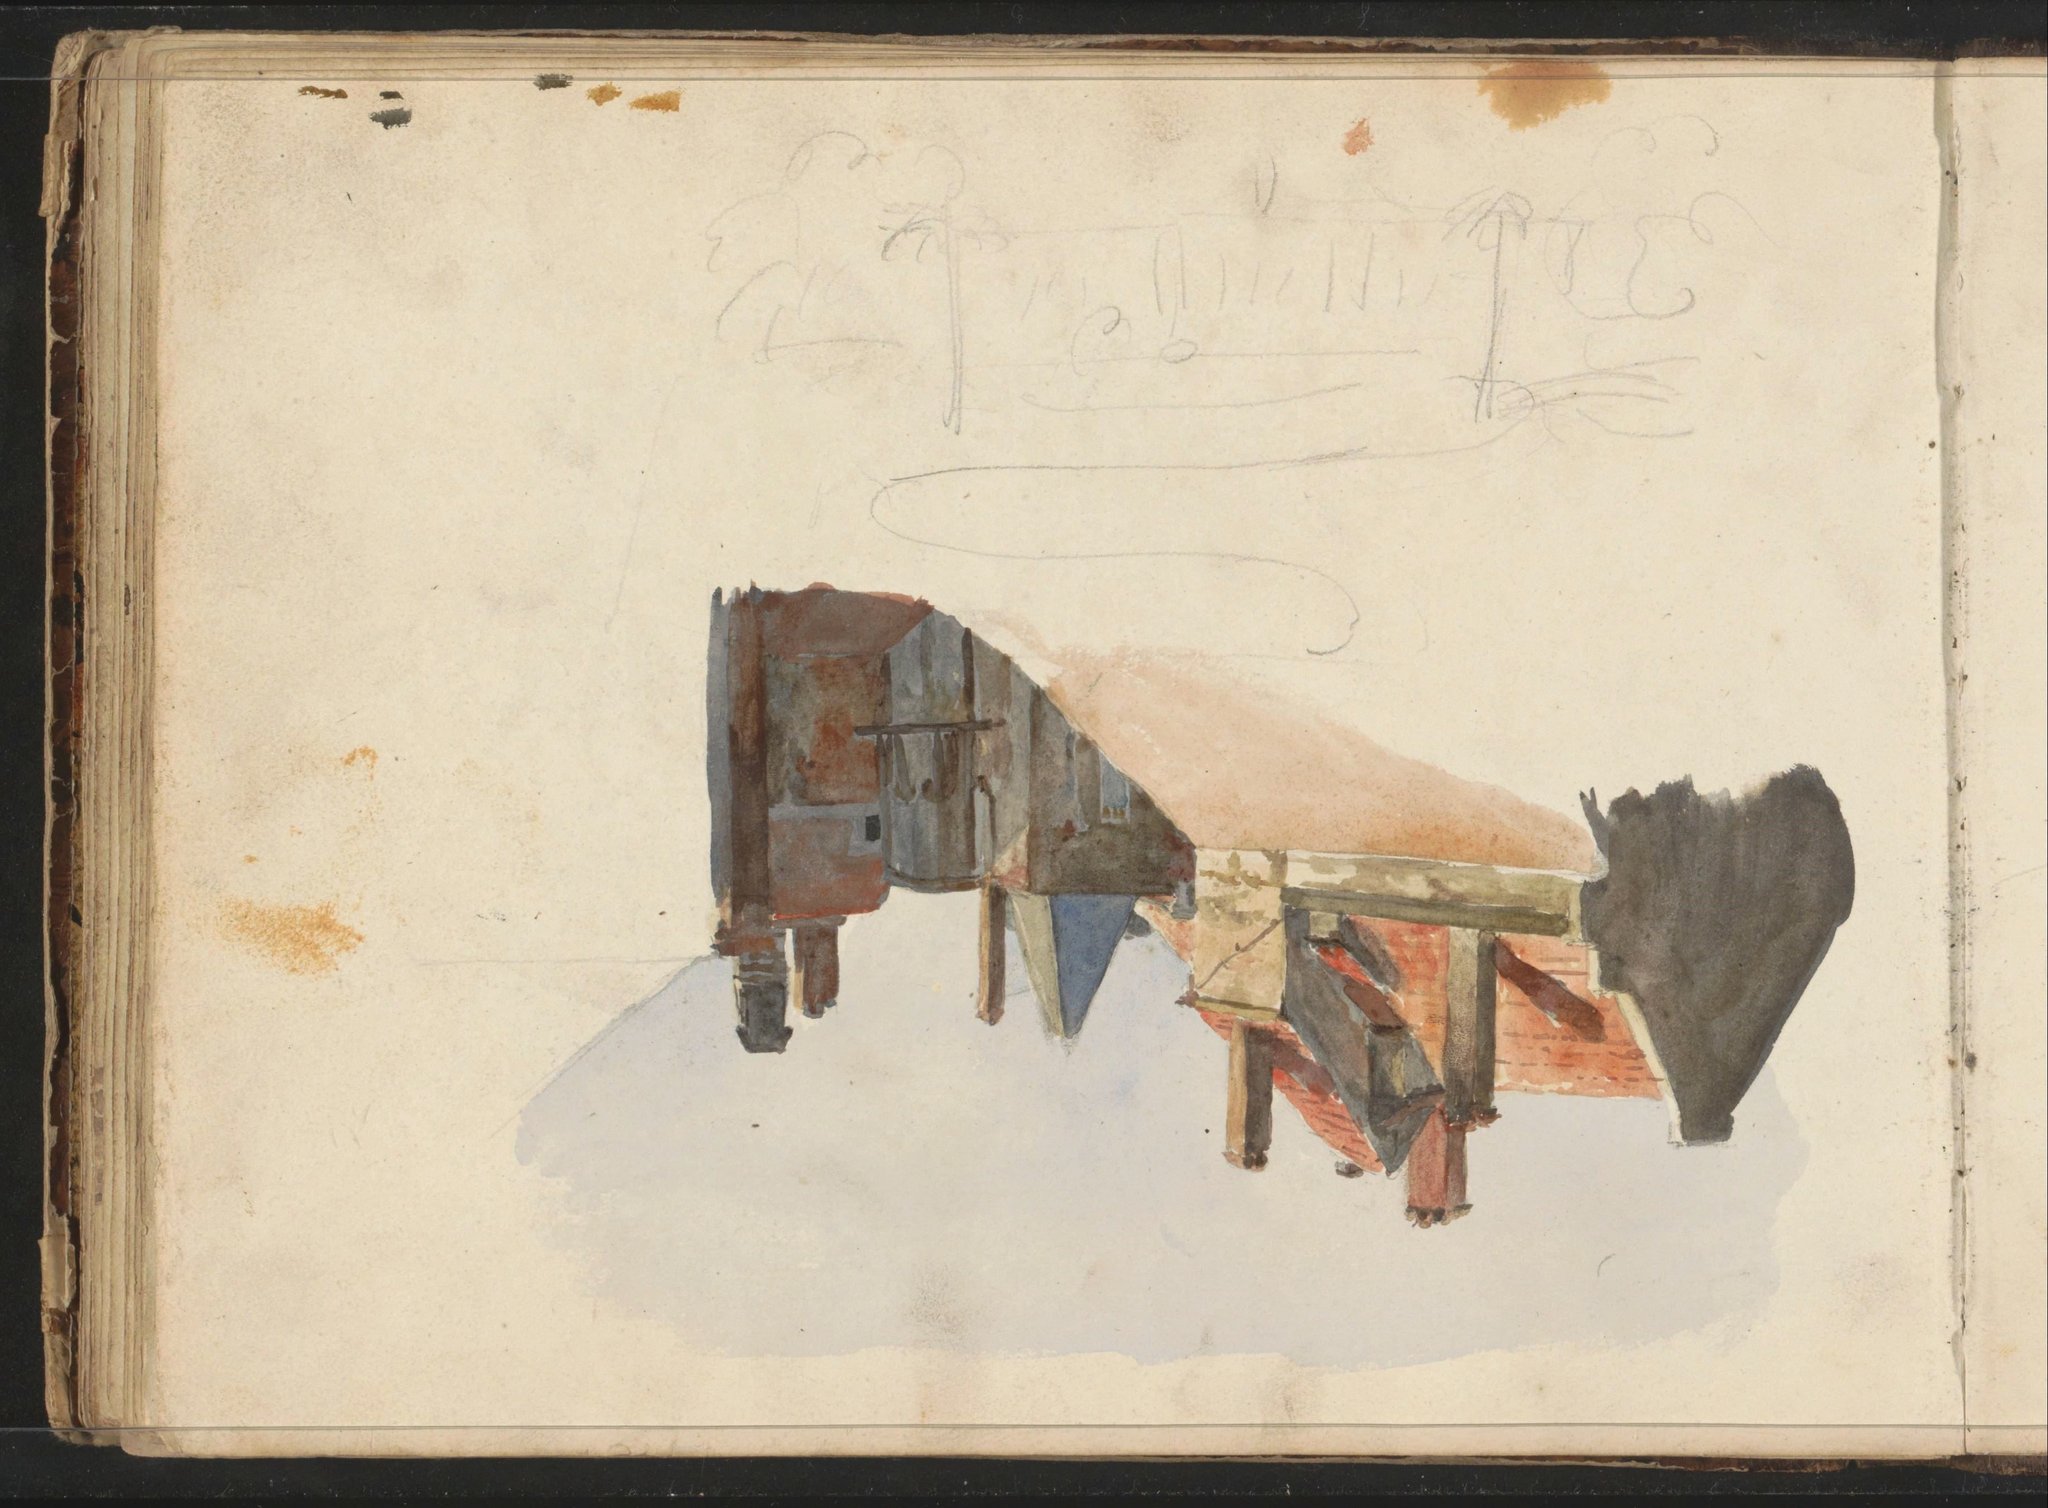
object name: sketchbook leaf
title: Daken met schoorstenen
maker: willem troost (ii)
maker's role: draughtsman, painter, print maker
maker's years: 1812-1893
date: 1822-1893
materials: paper, pencil, watercolor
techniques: brush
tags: chimney, roof (of house or building)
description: Tevens een studie van bomen, mogelijk langs een weg. Blad 55 verso uit een schetsboek met 36 bladen.